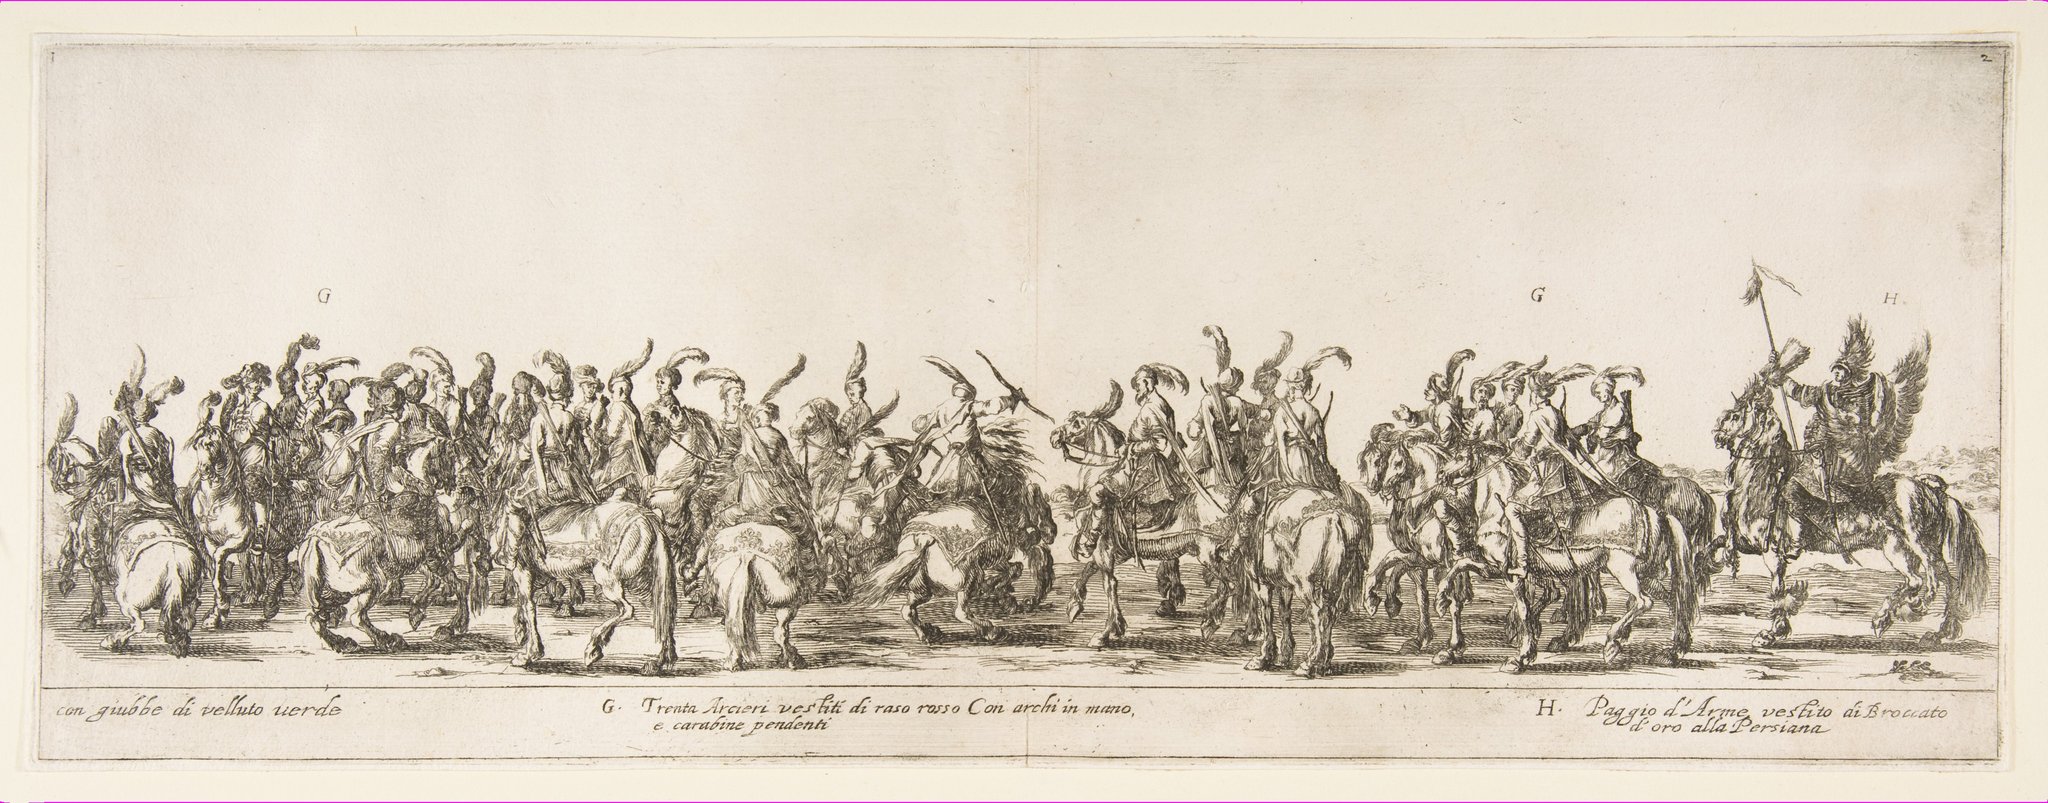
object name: print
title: Part of the Entrance of the Polish Legation (G and H)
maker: stefano della bella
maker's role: artist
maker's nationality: italian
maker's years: 1610-1664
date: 1633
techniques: etching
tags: soldiers,weapons,horses